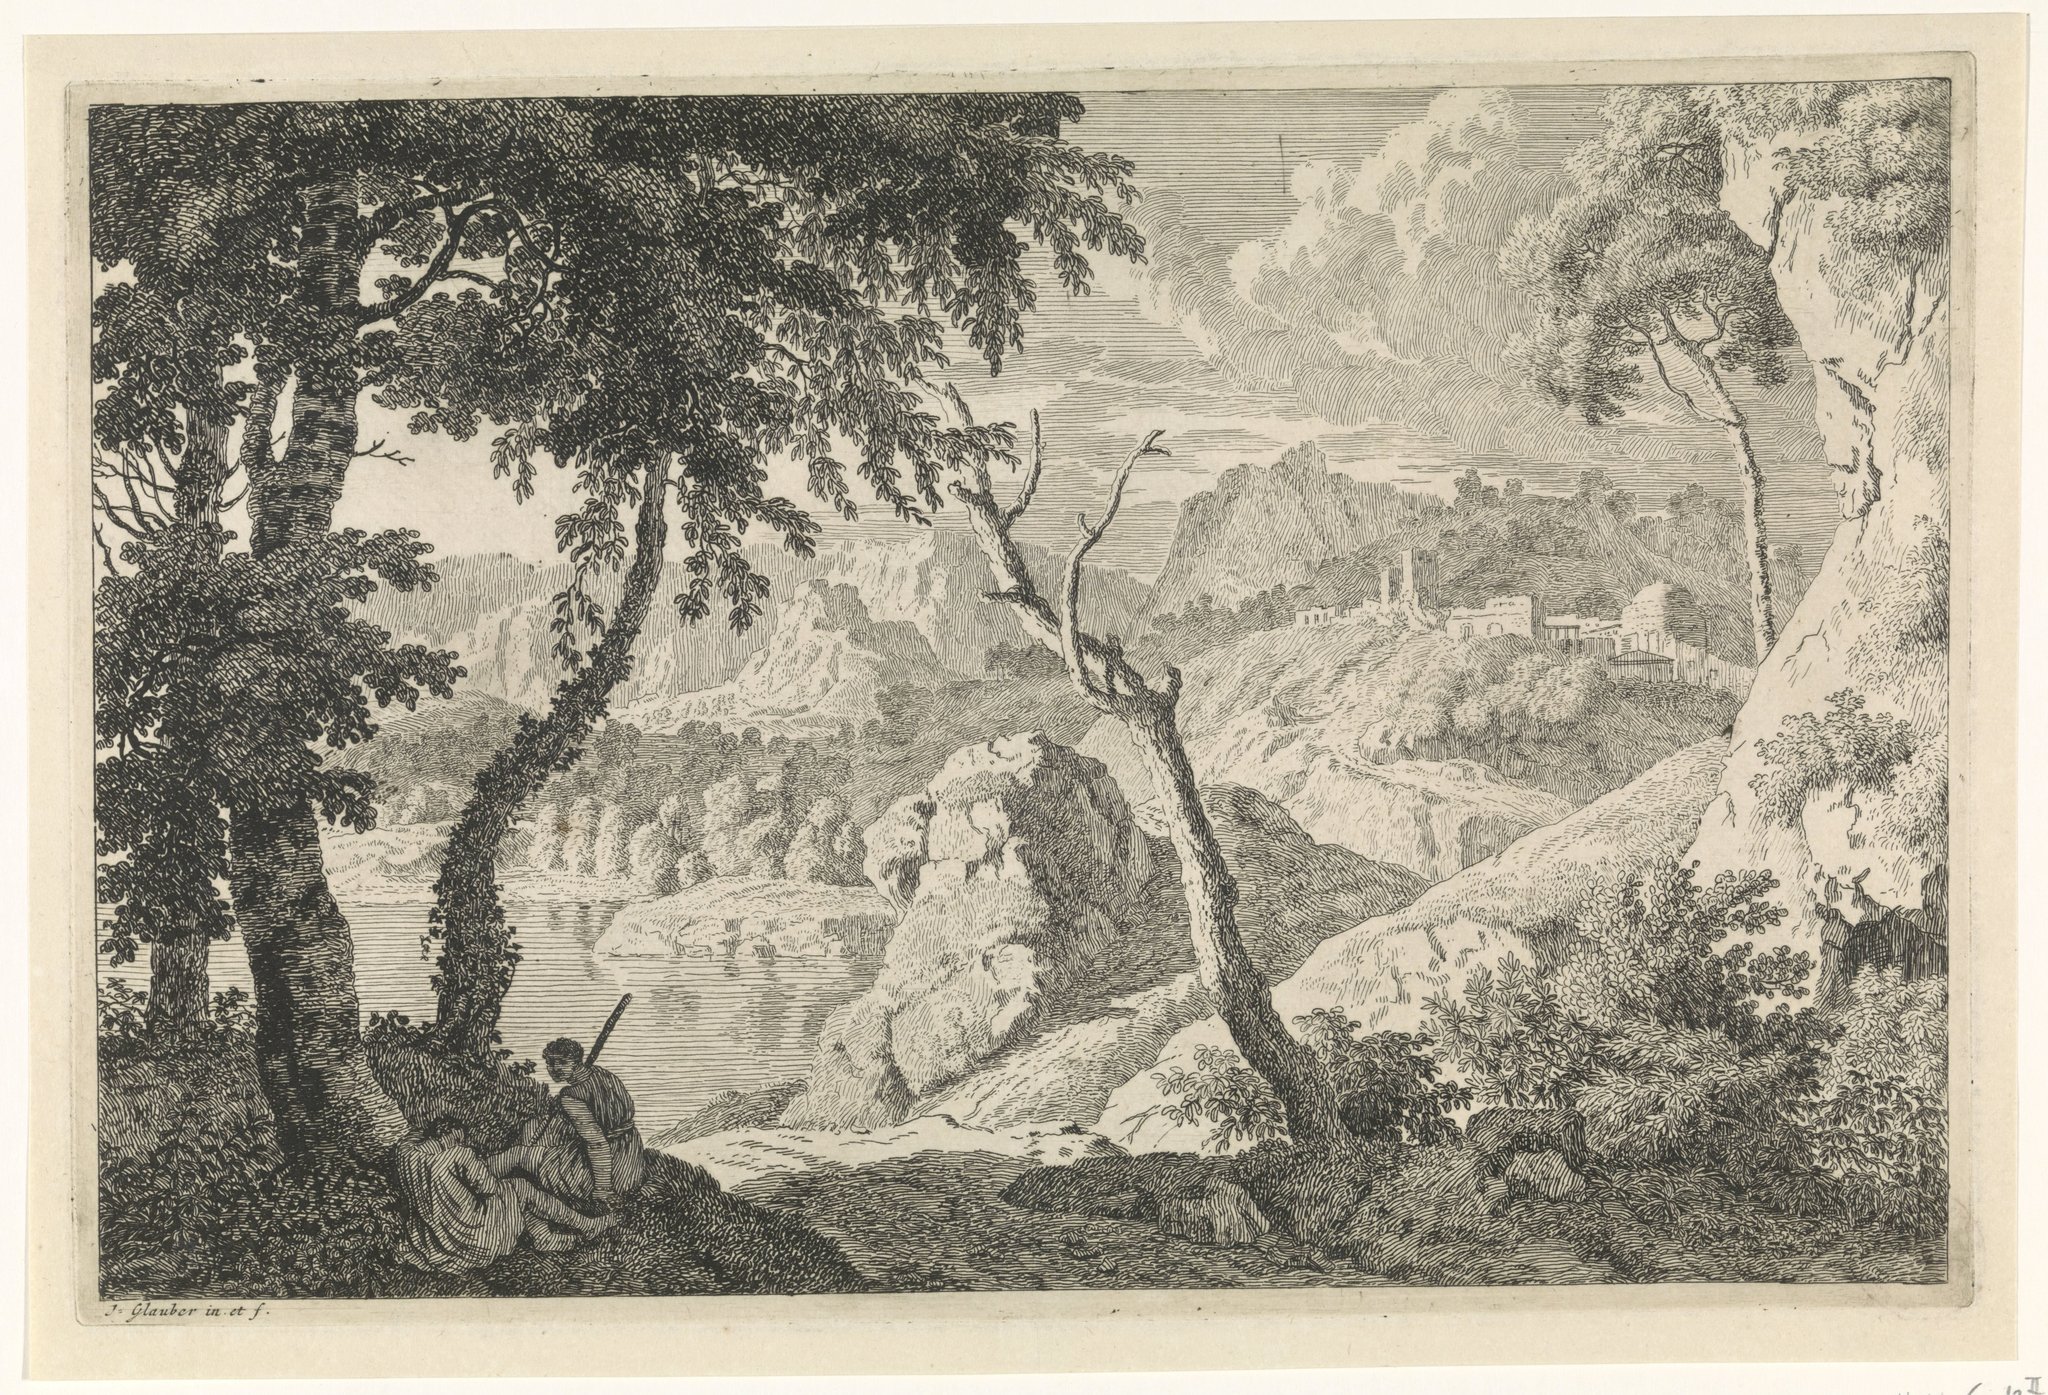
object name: print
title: Arcadische landschappen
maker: johannes glauber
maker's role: draughtsman, painter, print maker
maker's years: 1646-1726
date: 1656-1726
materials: paper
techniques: etching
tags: city-view, and landscape with man-made constructions, pastorals, arcadian scenes, lake (+ landscape with figures, staffage)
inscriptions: collector's mark: Lugt 240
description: Een arcadisch landschap met een meer. Op een heuvel langs het meer een stad. Op de voorgrond twee herders onder een boom. De prent maakt deel uit van een serie met arcadische landschappen.